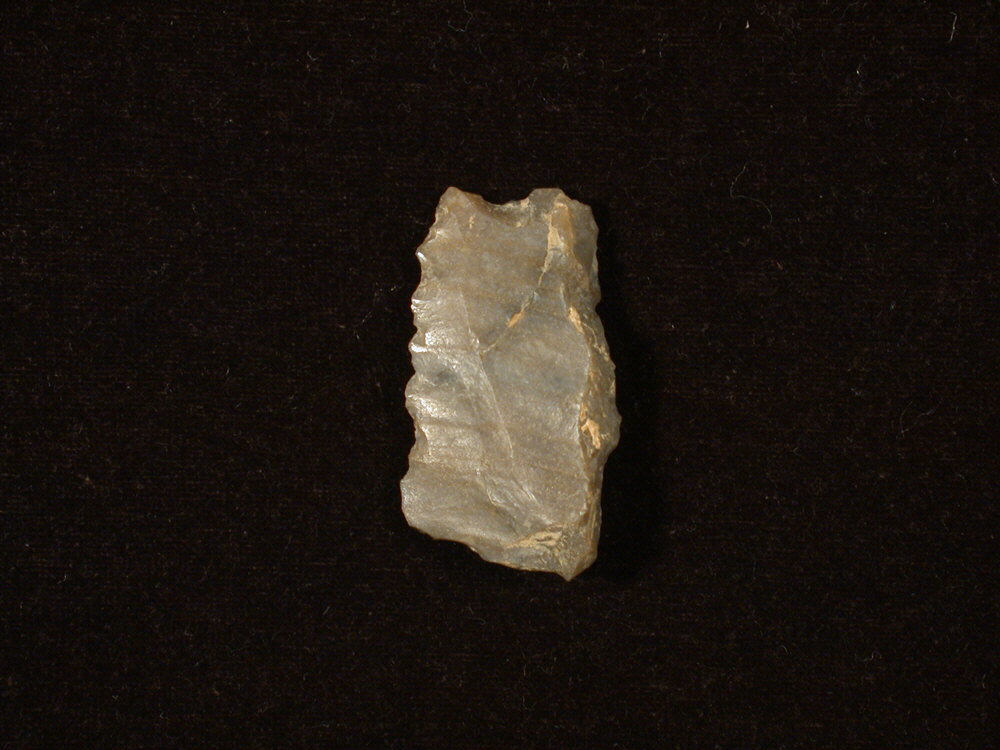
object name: knife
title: Blade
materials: stone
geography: iran